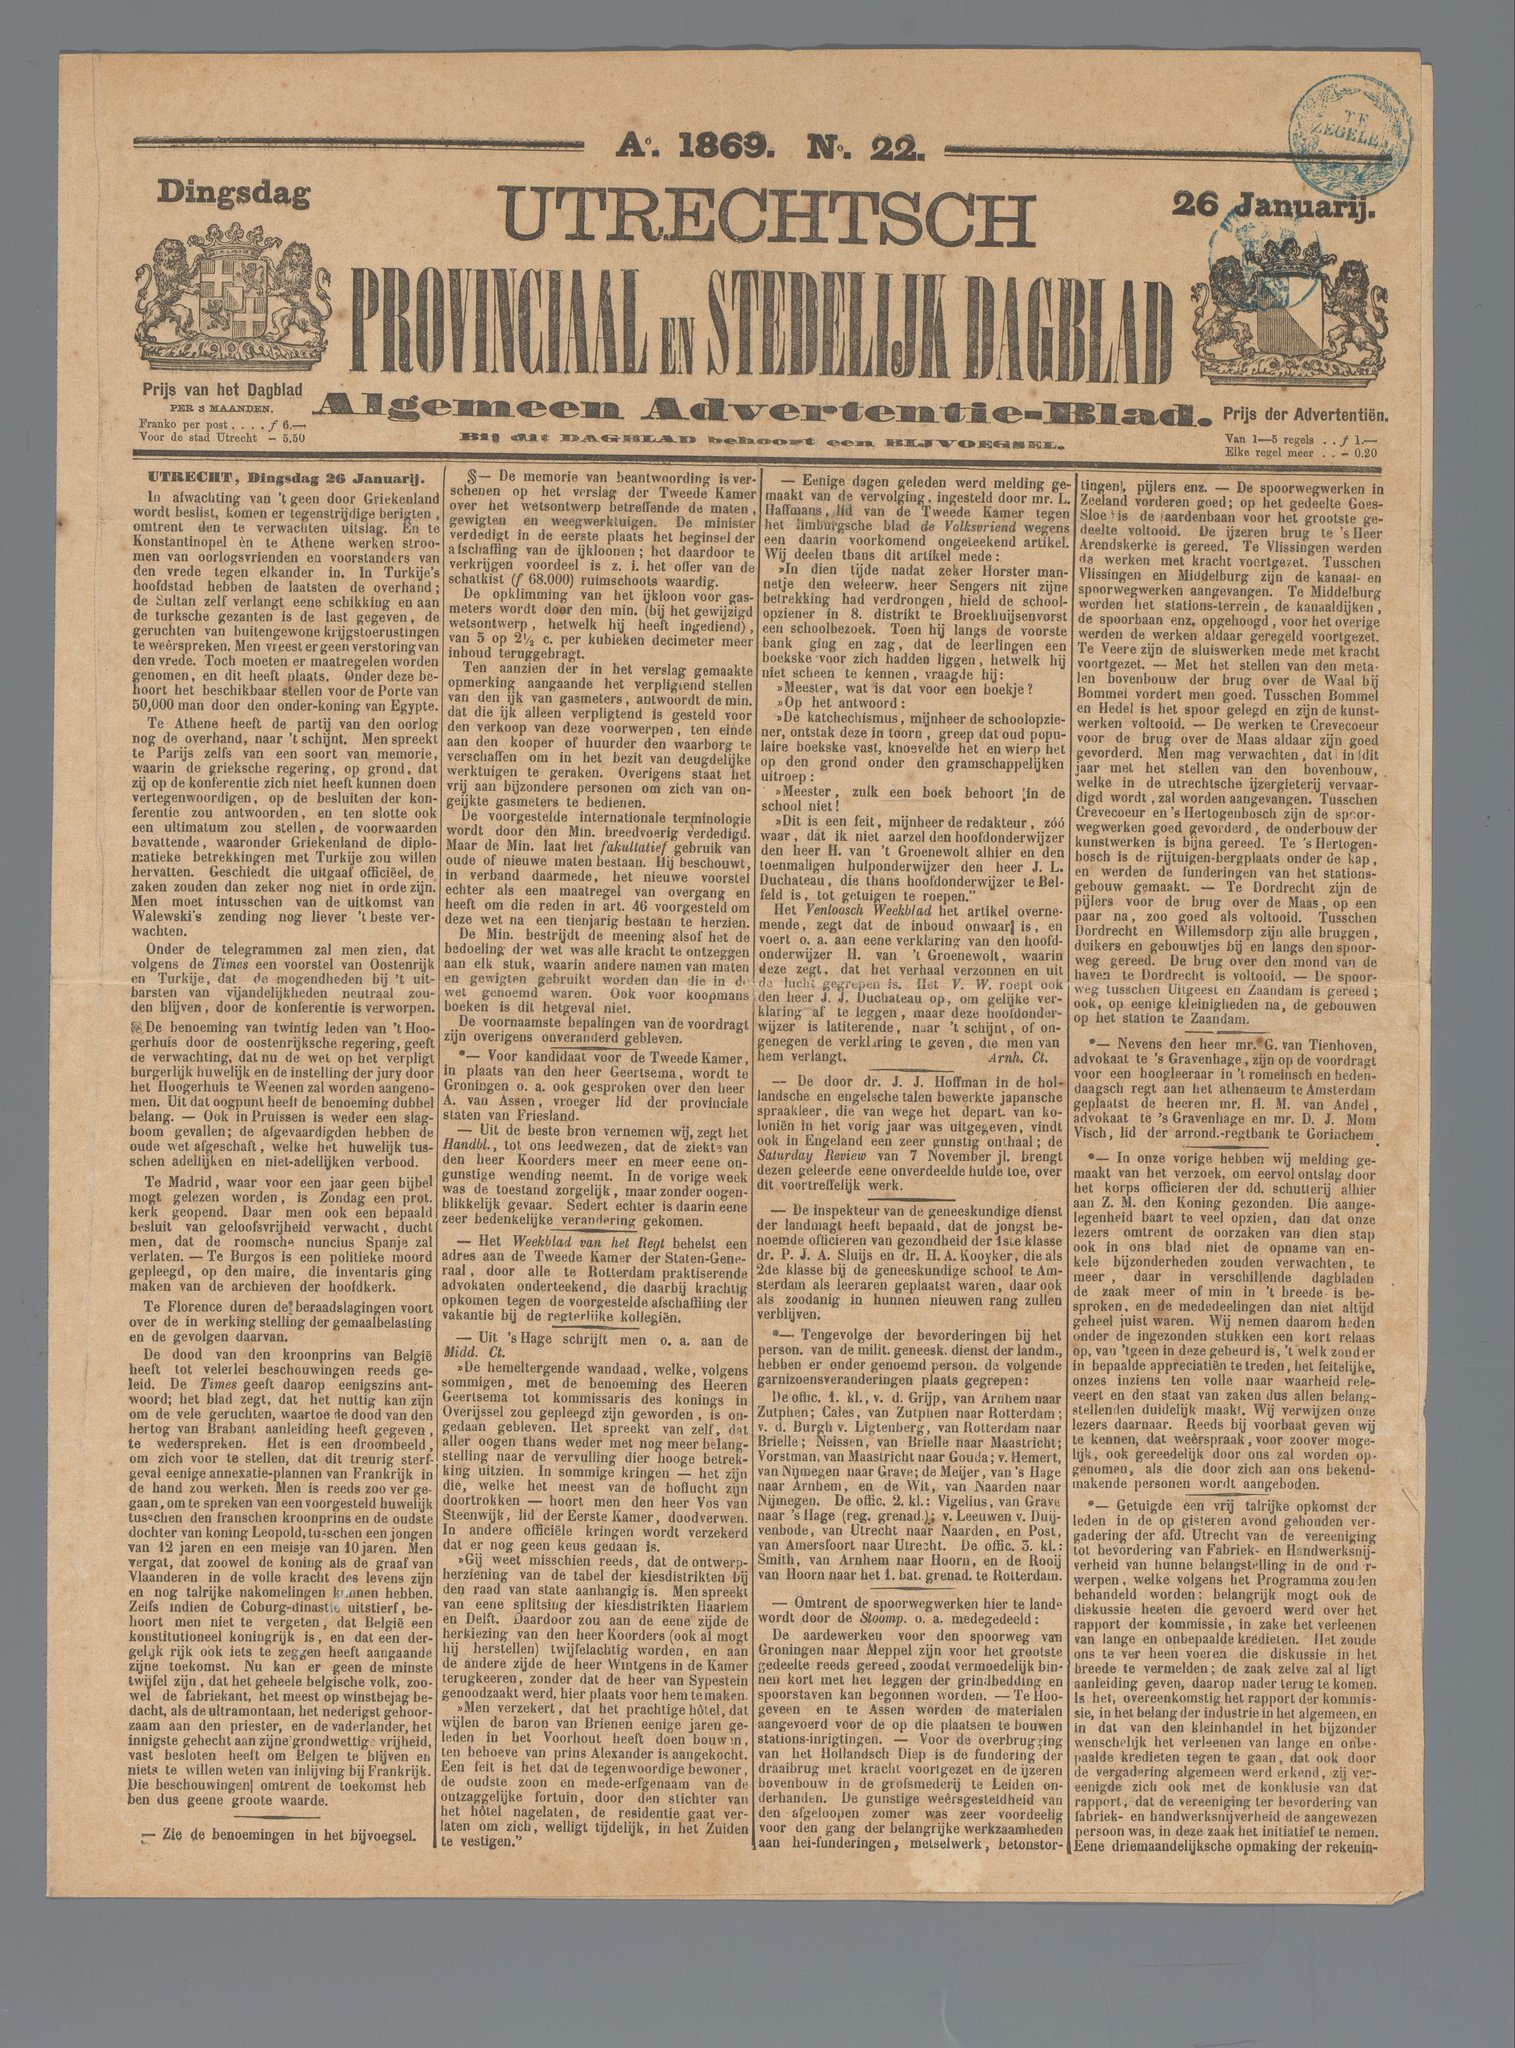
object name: newspaper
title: Utrechts provinciaal en stedelijk dagblad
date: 1869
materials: paper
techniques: printing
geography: utrecht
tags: netherlands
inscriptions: date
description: 4 pp, Ao. 1869, nr. 22. Gemerkt; r.b.: stempel: 'Te / Zegelen'. Gedateerd.